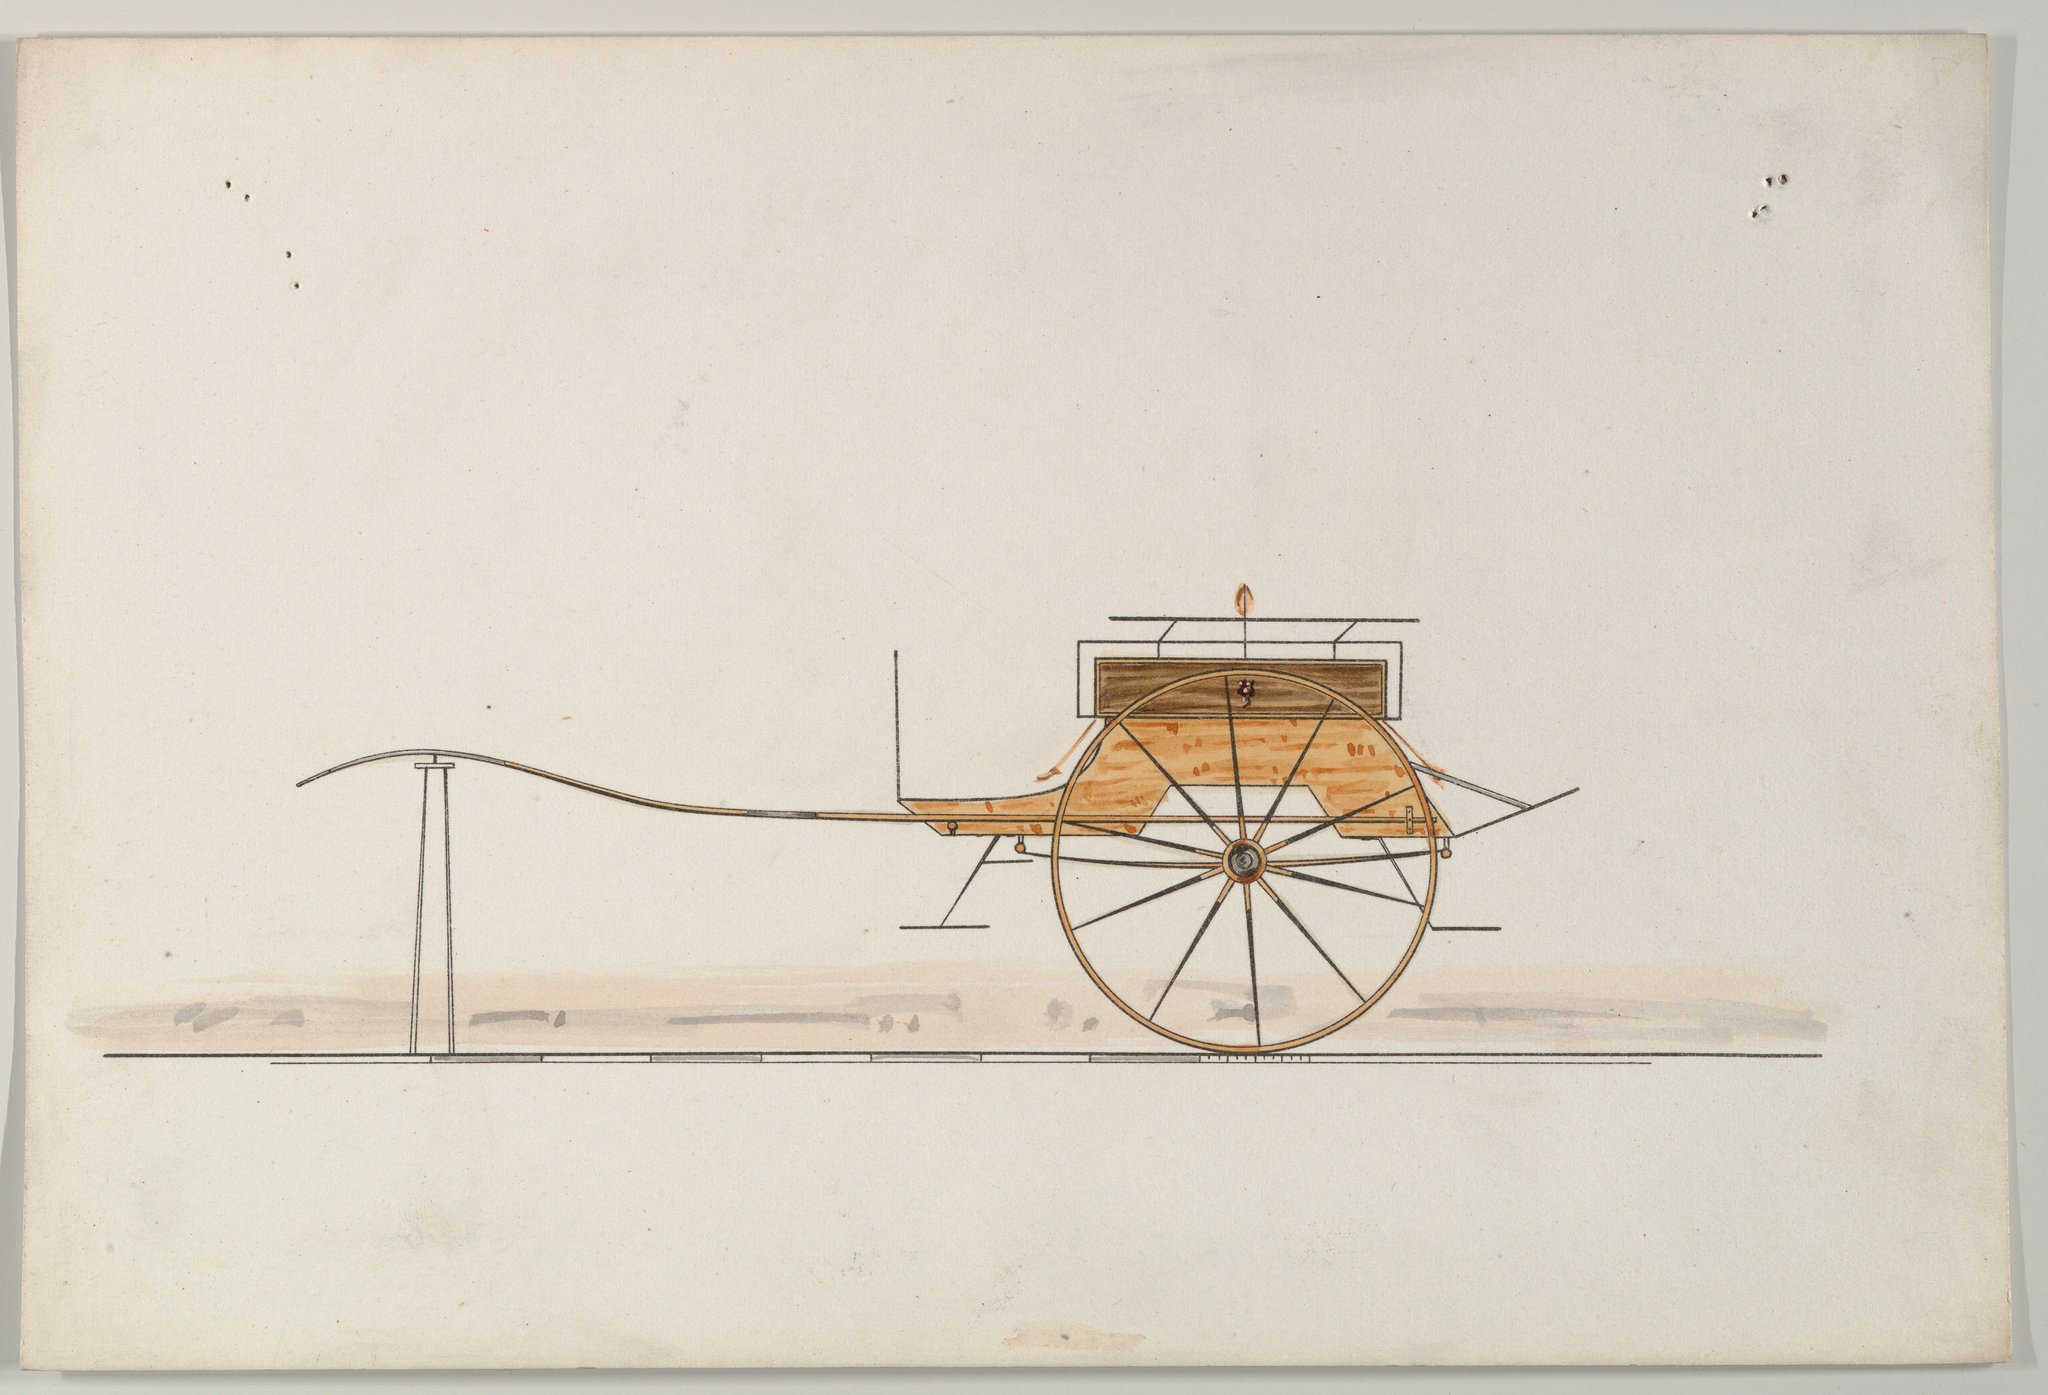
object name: drawing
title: Dos-a-Dos Cart (unnumbered)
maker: brewster & co.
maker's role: manufacturer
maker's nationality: american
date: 1850-1874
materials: gouache, graphite, gum arabic, watercolor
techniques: pen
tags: carriages